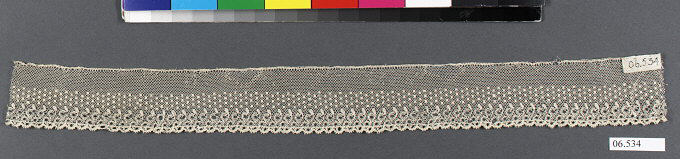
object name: strip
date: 1830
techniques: lace